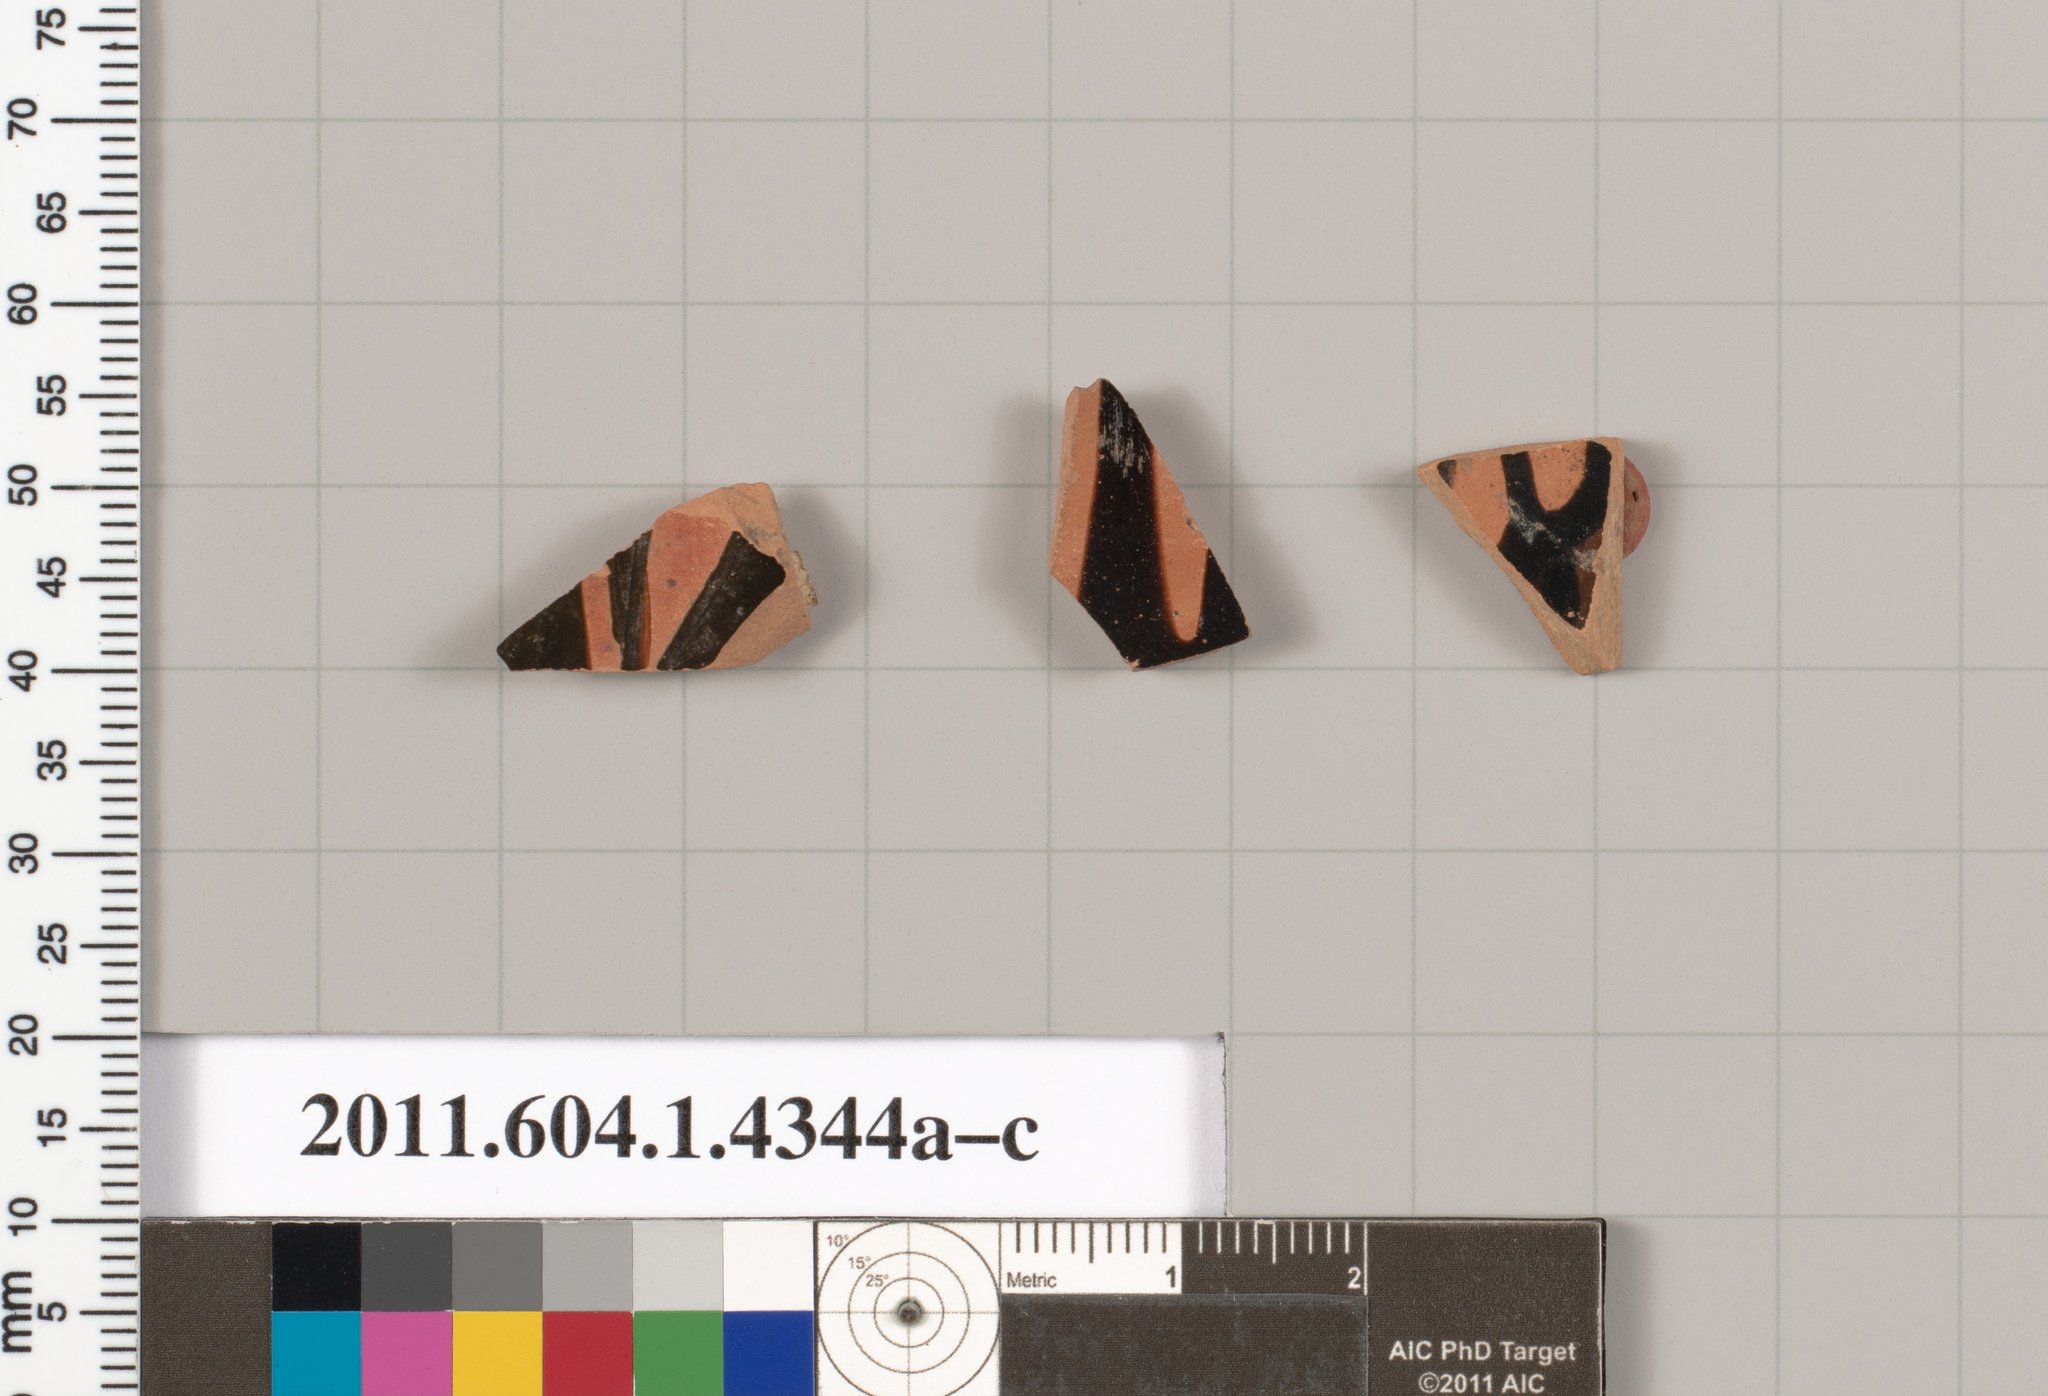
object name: kylix fragment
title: Terracotta fragments of kylikes (drinking cups)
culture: greek, attic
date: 500-451 BCE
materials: terracotta